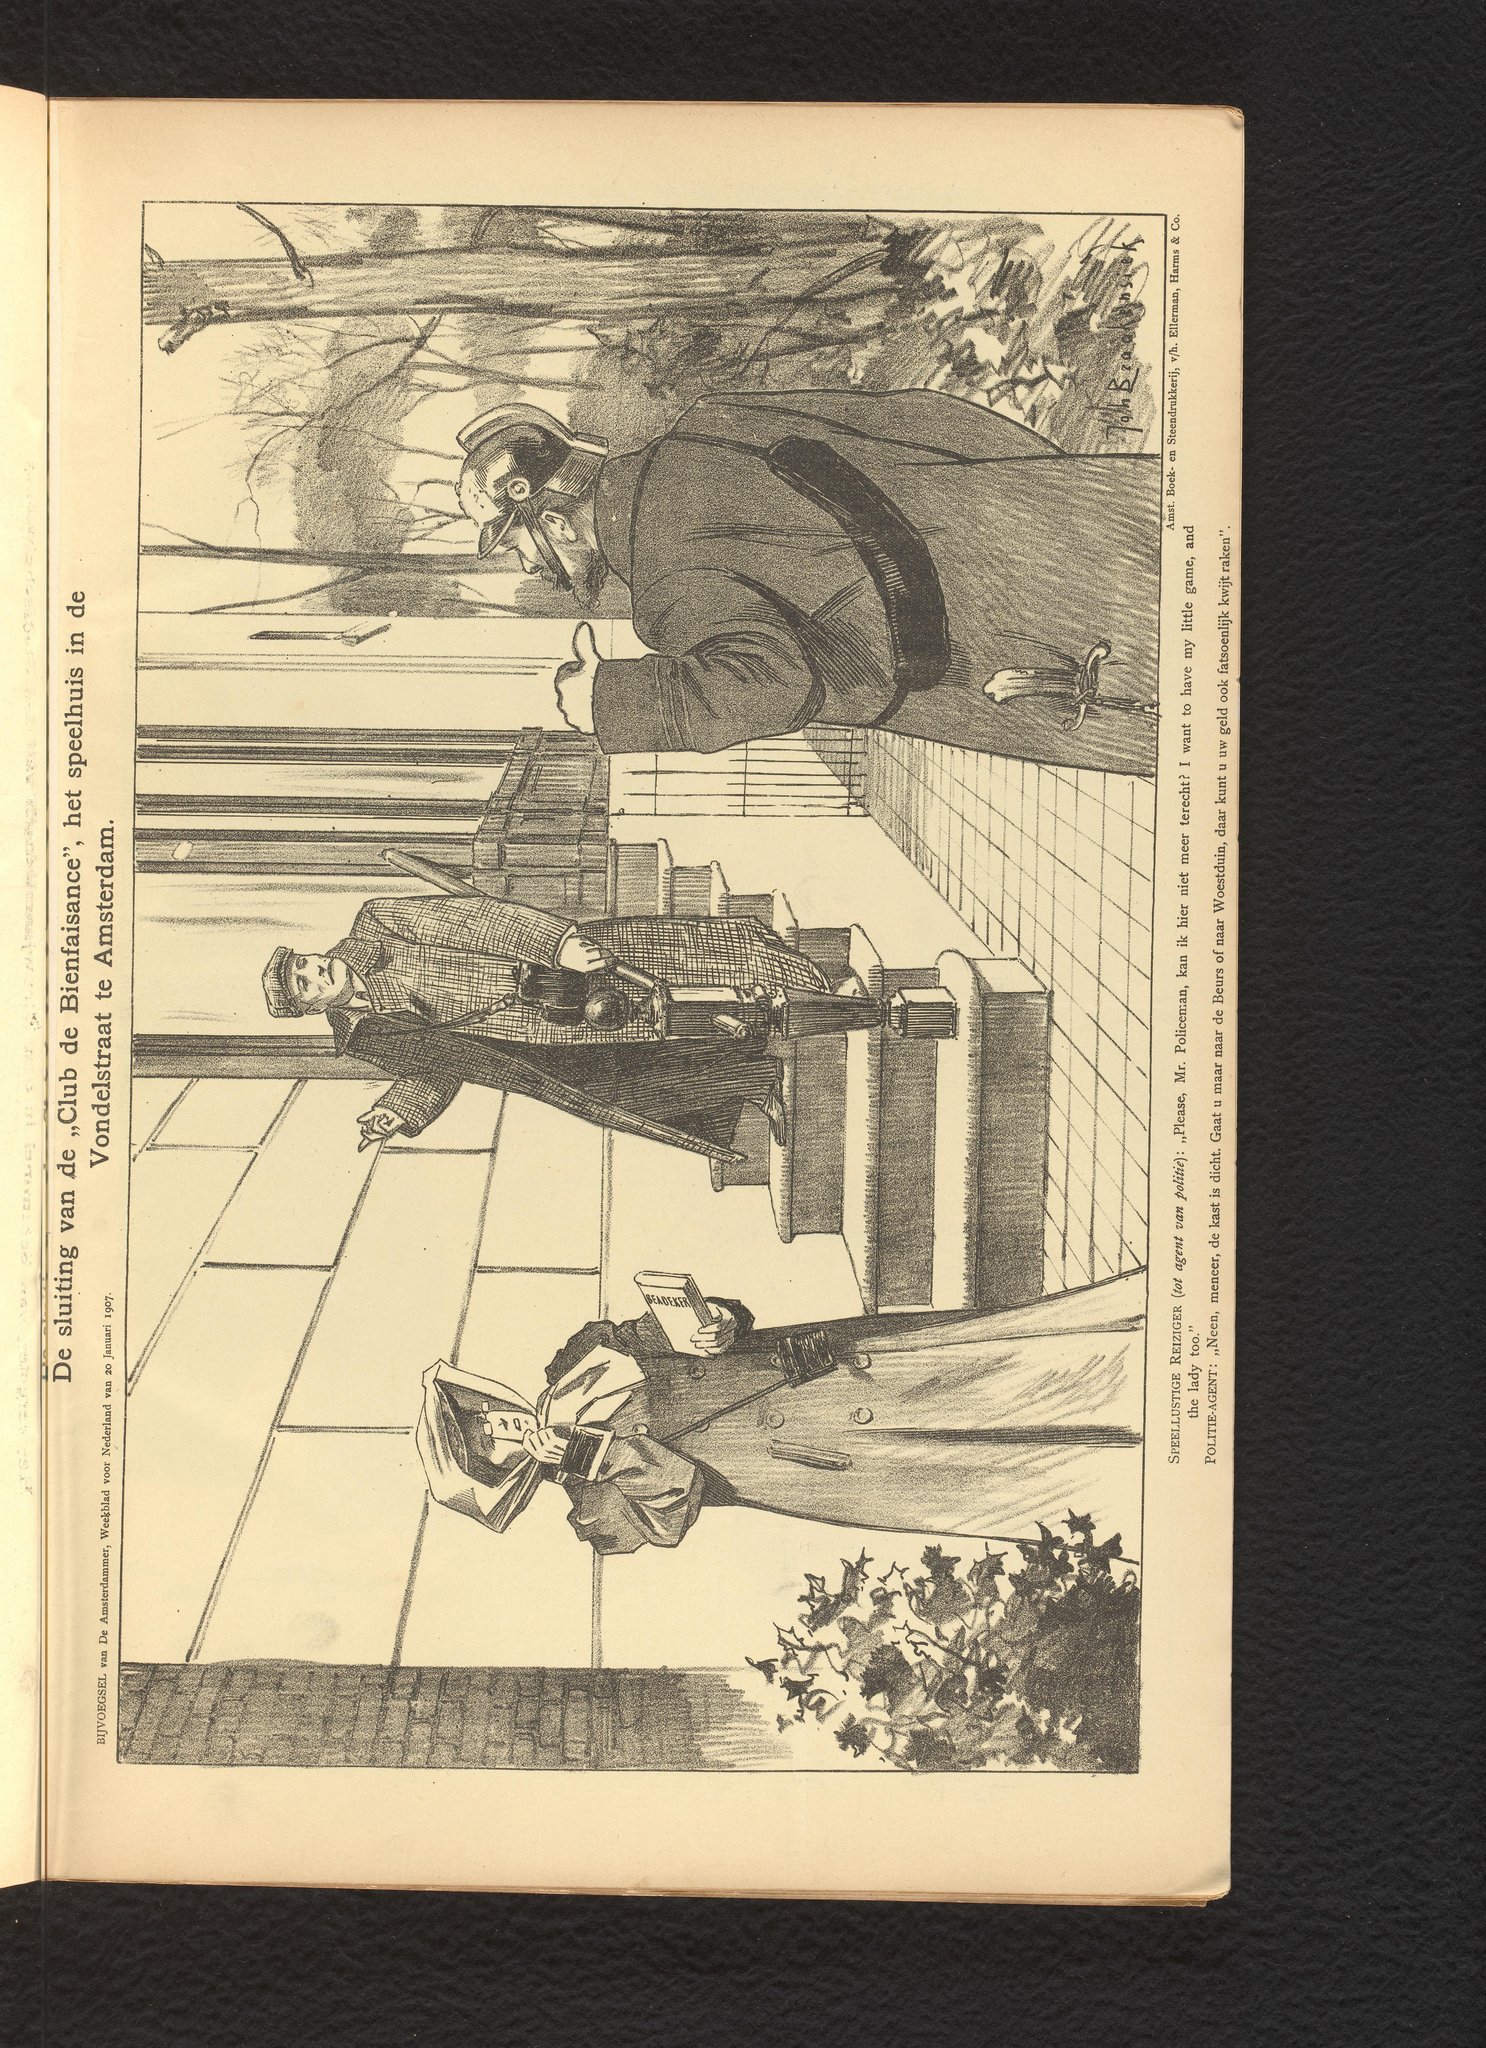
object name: cartoon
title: De sluiting van de "Club de Bienfaisance", het speelhuis in de Vondelstraat te Amsterdam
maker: johan braakensiek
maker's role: draughtsman, print maker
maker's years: 1858-1940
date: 1907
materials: paper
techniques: lithograph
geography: netherlands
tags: policeman, constable, gaming den, gambling den, political caricatures and satires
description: Twee buitenlandse reizigers klagen bij een politieagent over de sluiting van het etablissement in de Amsterdamse Vondelstraat waar gegokt kon worden.